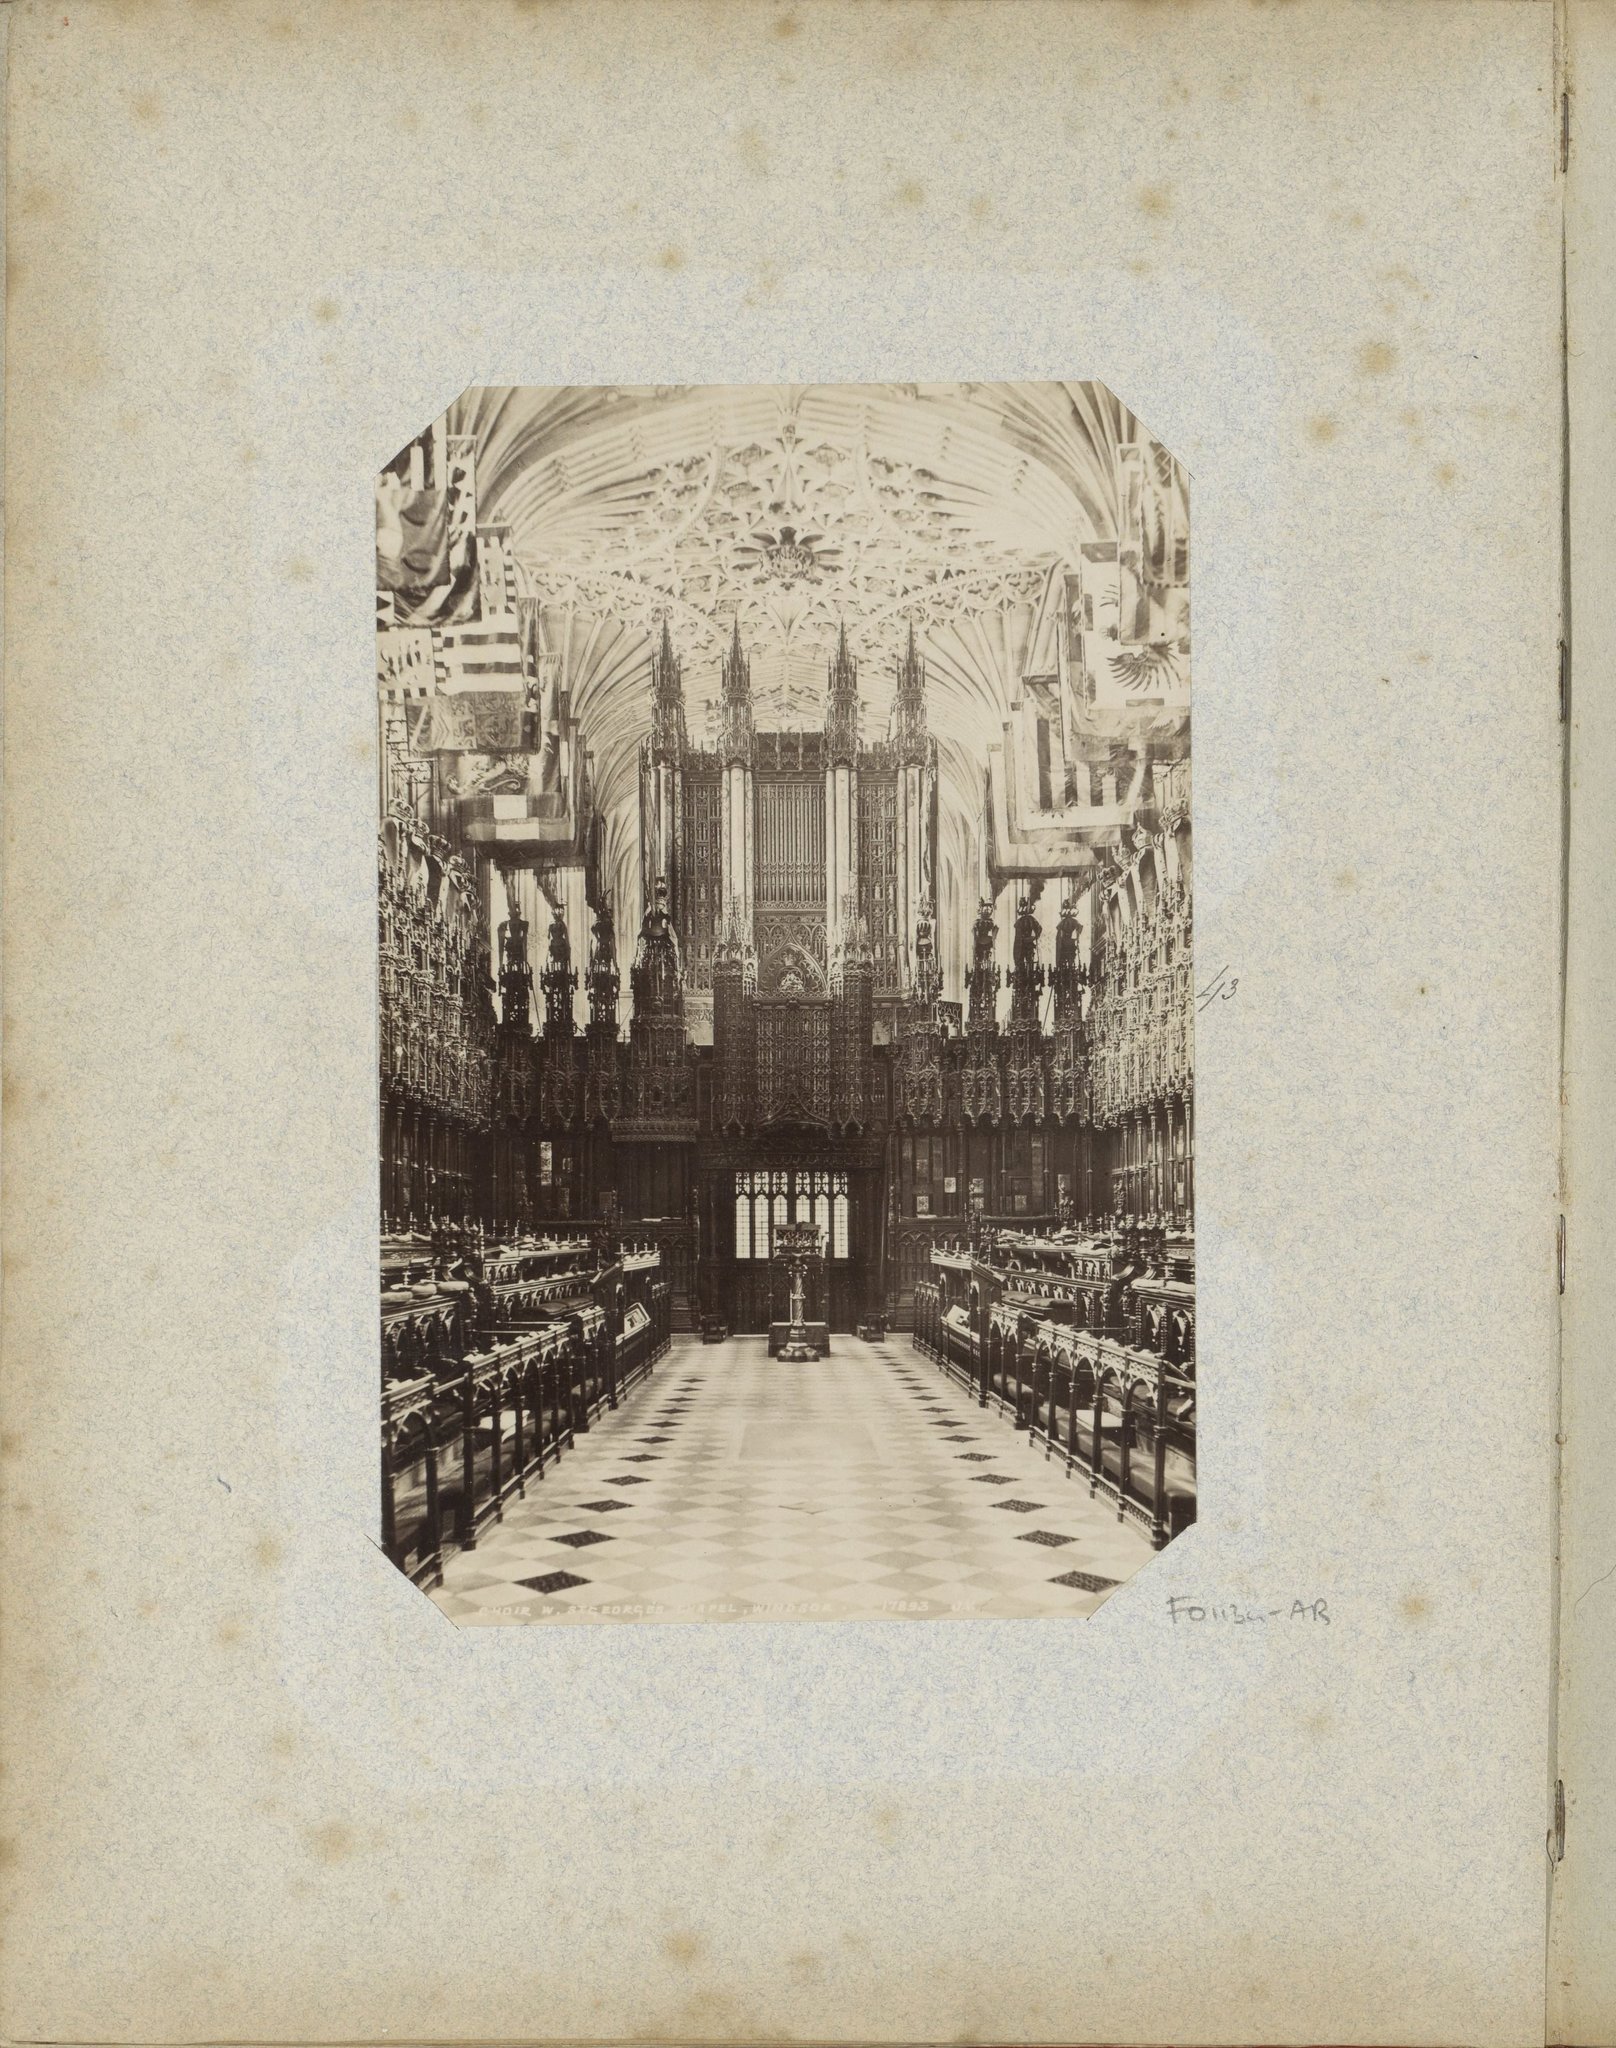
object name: album leaf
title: Choir W. St George's Chapel, Windsor Castle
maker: Anonymous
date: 1880-1910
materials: paper, photographic support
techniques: albumen print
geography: london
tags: parts of church interior: choir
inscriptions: inscription: ‘O.[...]’, number: ‘17893’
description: Onderdeel van Reisalbum met bezienswaardigheden in Engeland, Zwitserland, Frankrijk en Duitsland.